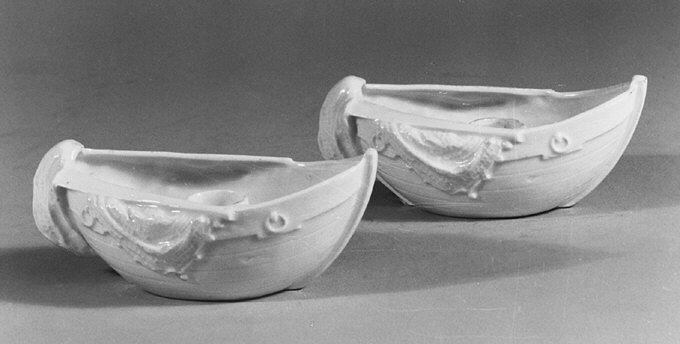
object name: candlestick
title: Pair of boat-shaped candlesticks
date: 1801-1900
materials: hard paste porcelain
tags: boats